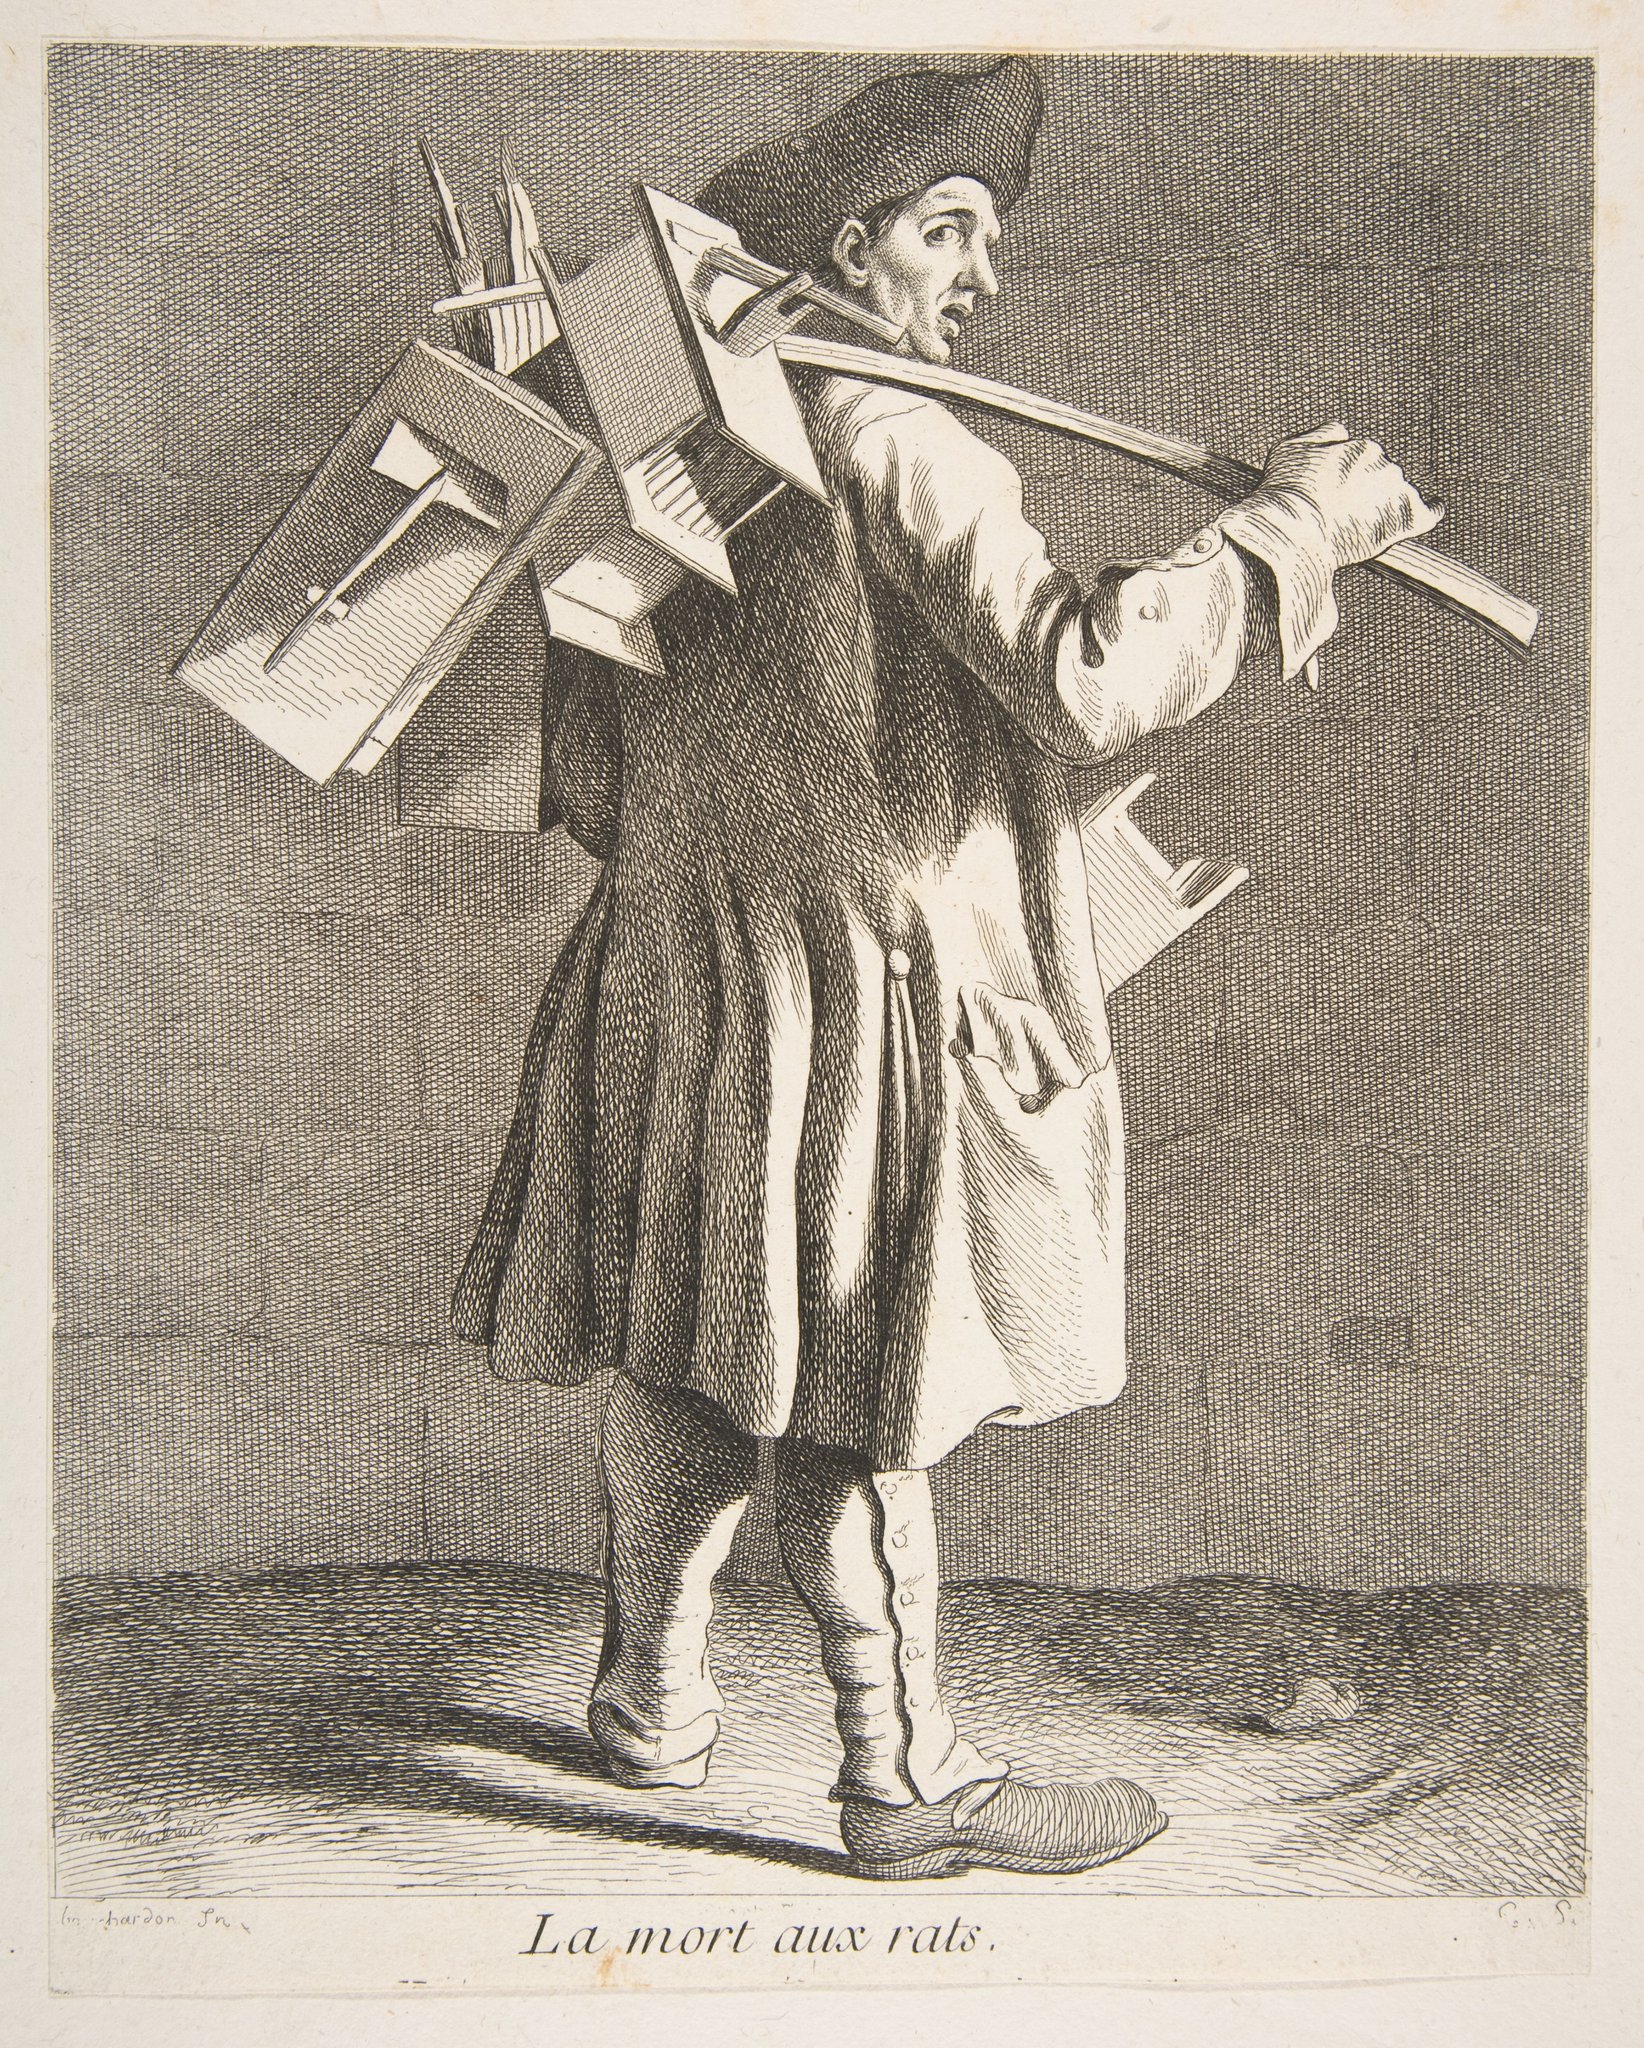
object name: print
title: The Rat Catcher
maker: anne claude philippe de tubières, comte de caylus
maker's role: artist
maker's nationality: french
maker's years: 1692-1765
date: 1746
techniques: engraving, etching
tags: men,rats